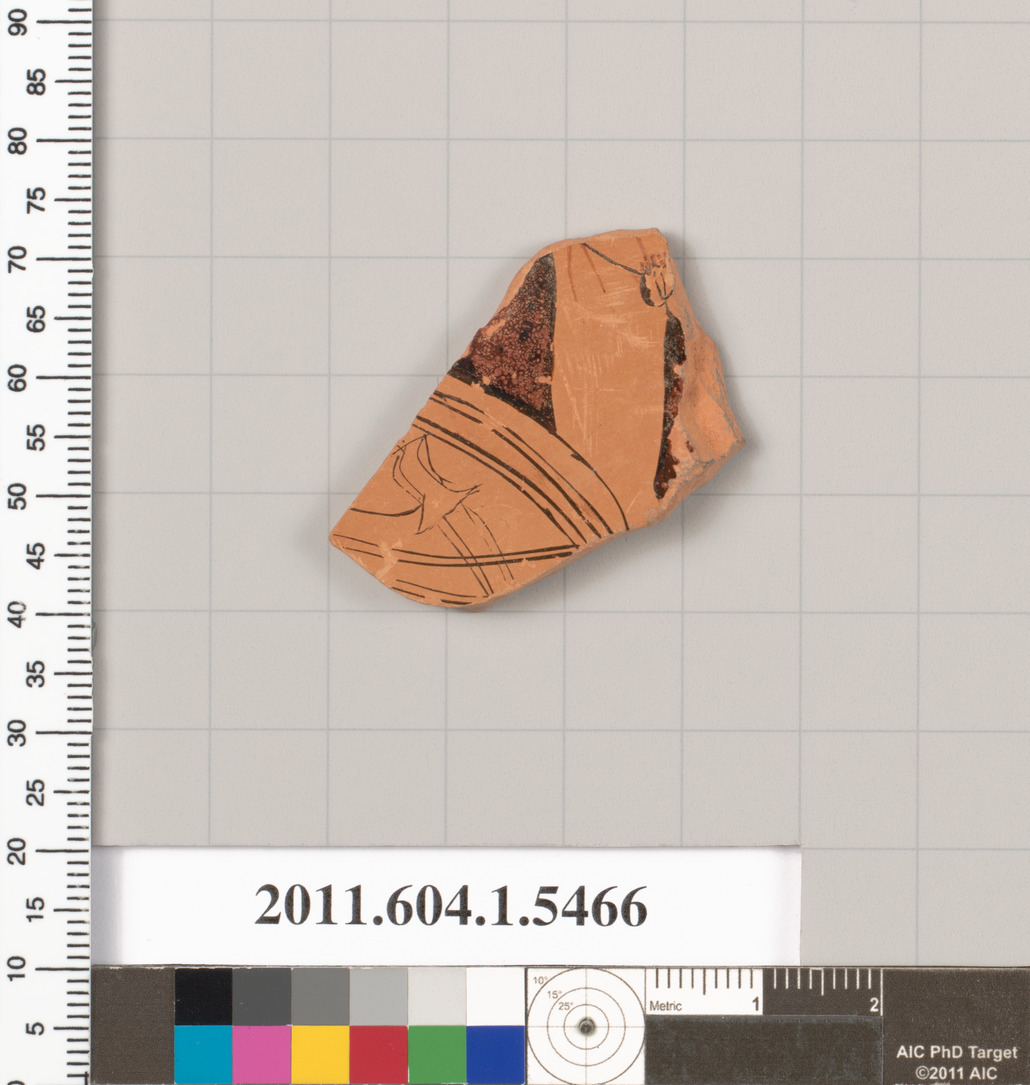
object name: kylix fragment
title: Terracotta fragment of a kylix (drinking cup)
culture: greek, attic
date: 500-480 BCE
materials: terracotta